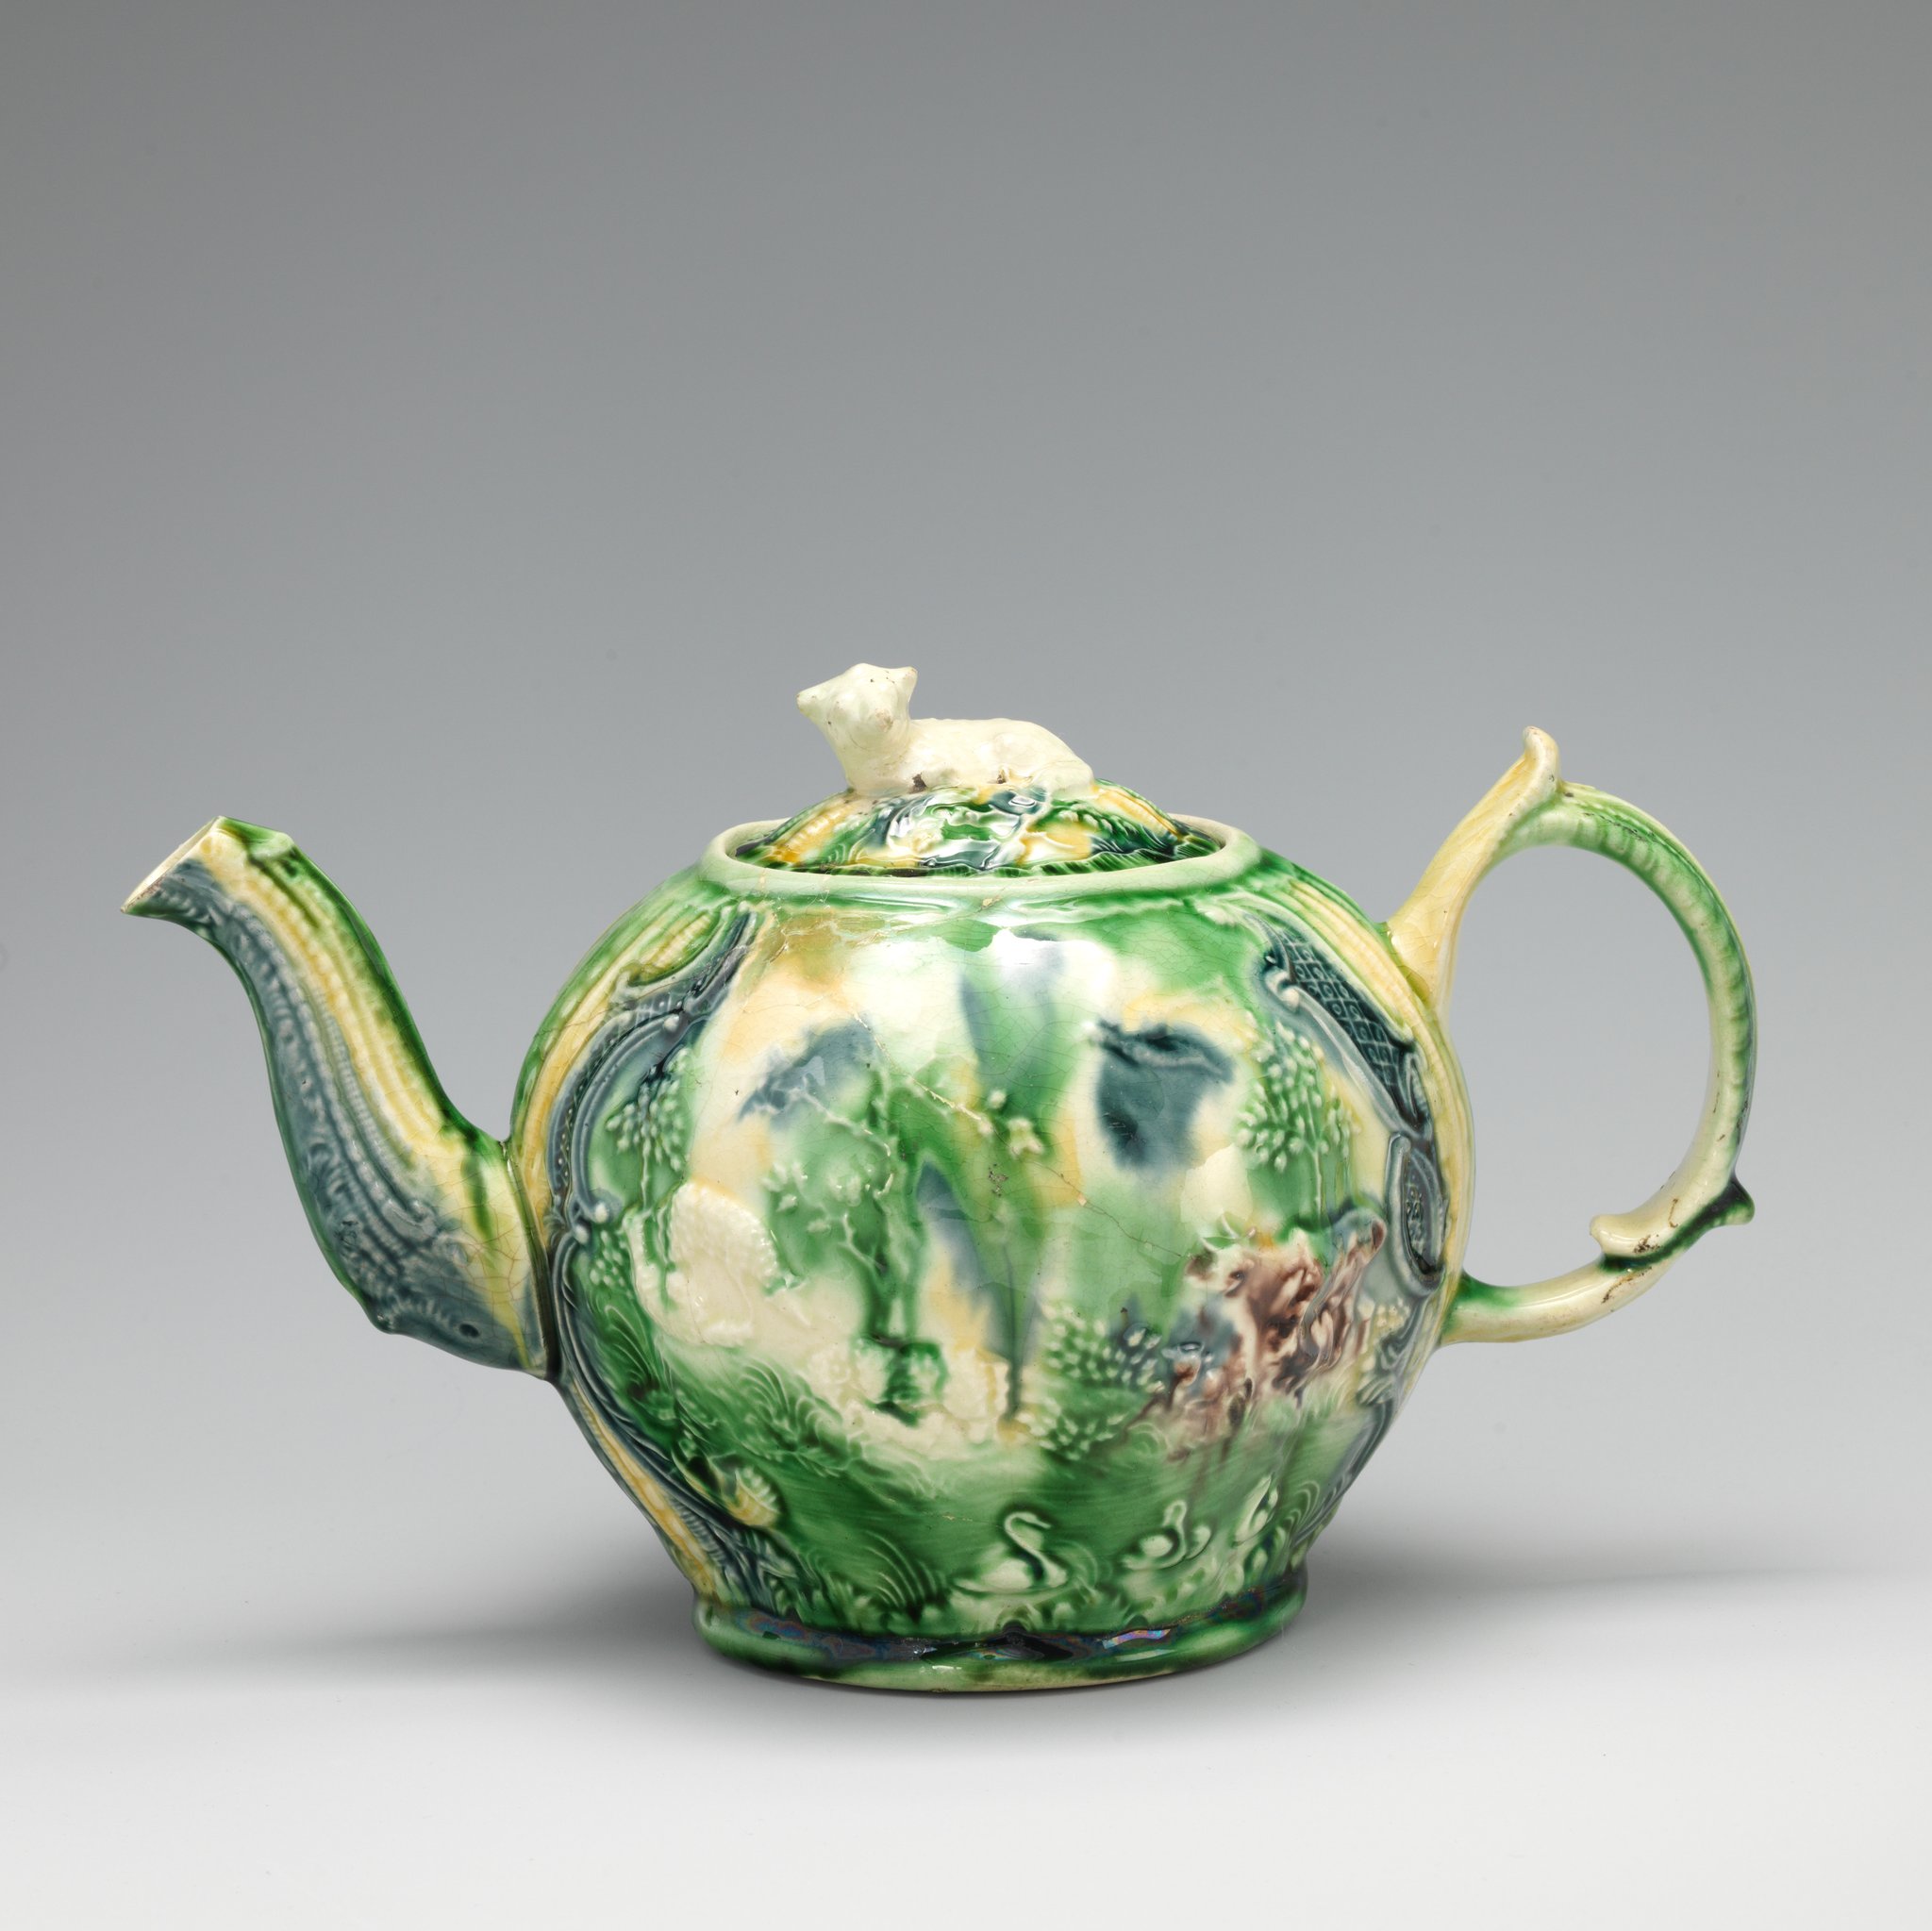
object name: teapot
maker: whieldon type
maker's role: maker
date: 1760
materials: earthenware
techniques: glazing